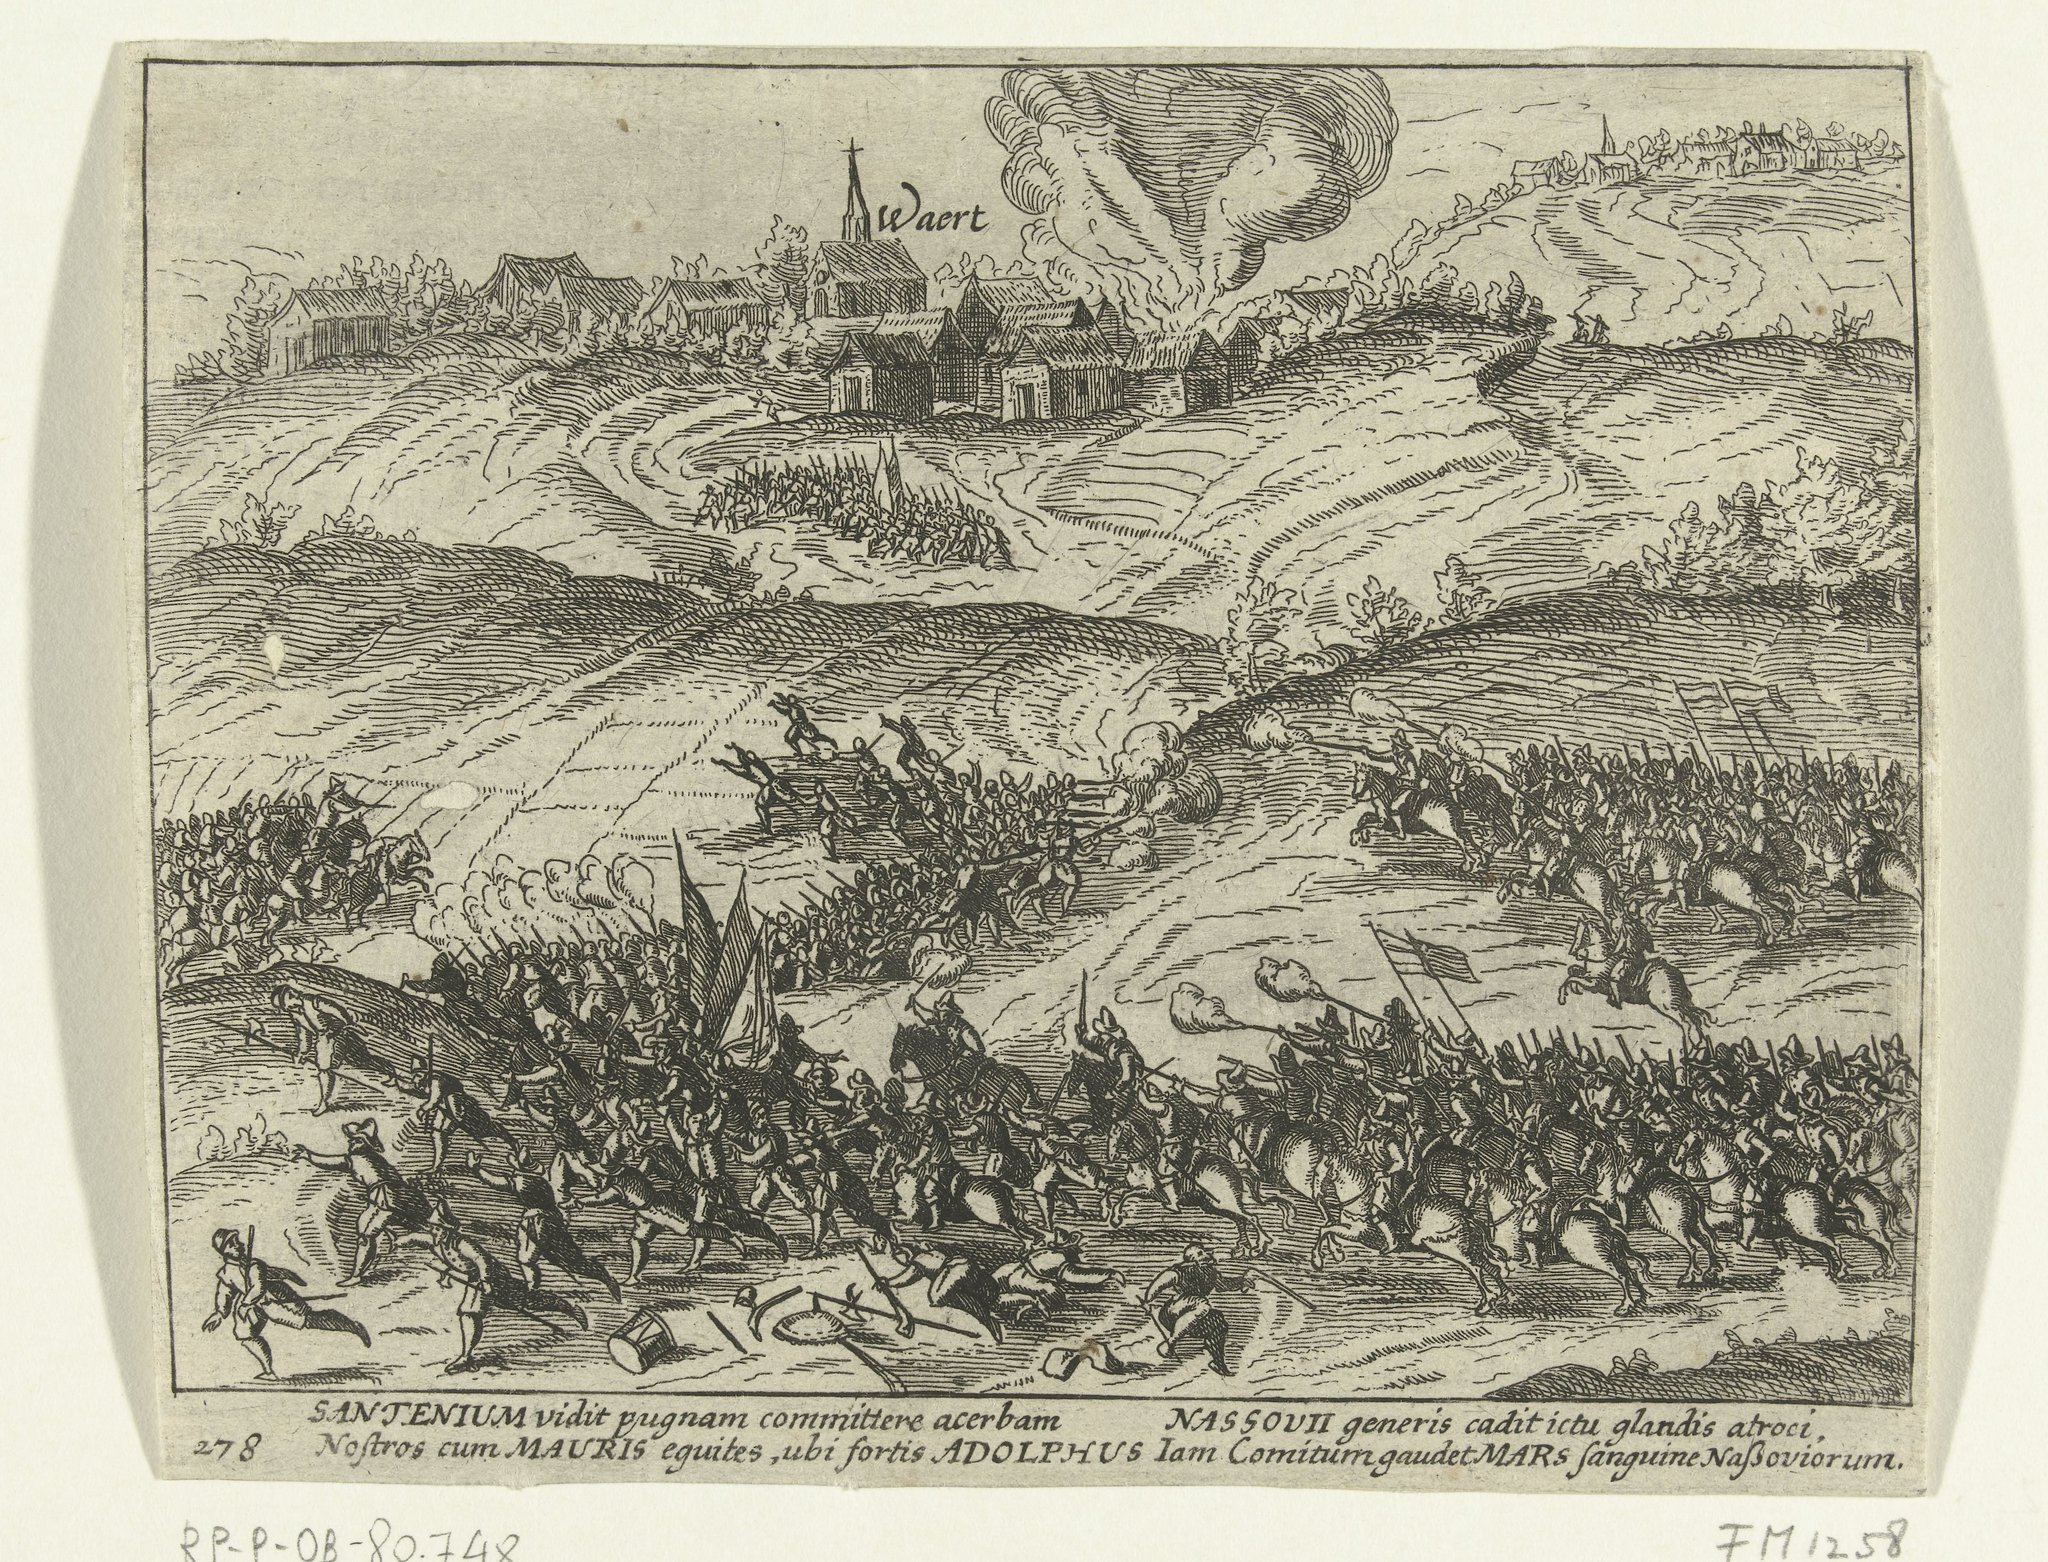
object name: history print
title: Gevechten bij Xanten en Rheinberg waarbij graaf Adolf van Nassau-Siegen sneuvelt, 1608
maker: Anonymous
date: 1613-1615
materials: paper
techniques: etching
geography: northern netherlands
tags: earl, battle (+ land forces)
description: Gevechten tussen het Staatse en het Spaanse leger bij Xanten en Rheinberg waarbij graaf Adolf van Nassau-Siegen sneuvelt, maar het Staatse leger overwint, 19 november 1608. Op de achtergrond het plaatsje Wardt. Met onderschrift van 4 regels in het Latijn. Genummerd: 278. Bedrukt op achterzijde met tekst in het Latijn.